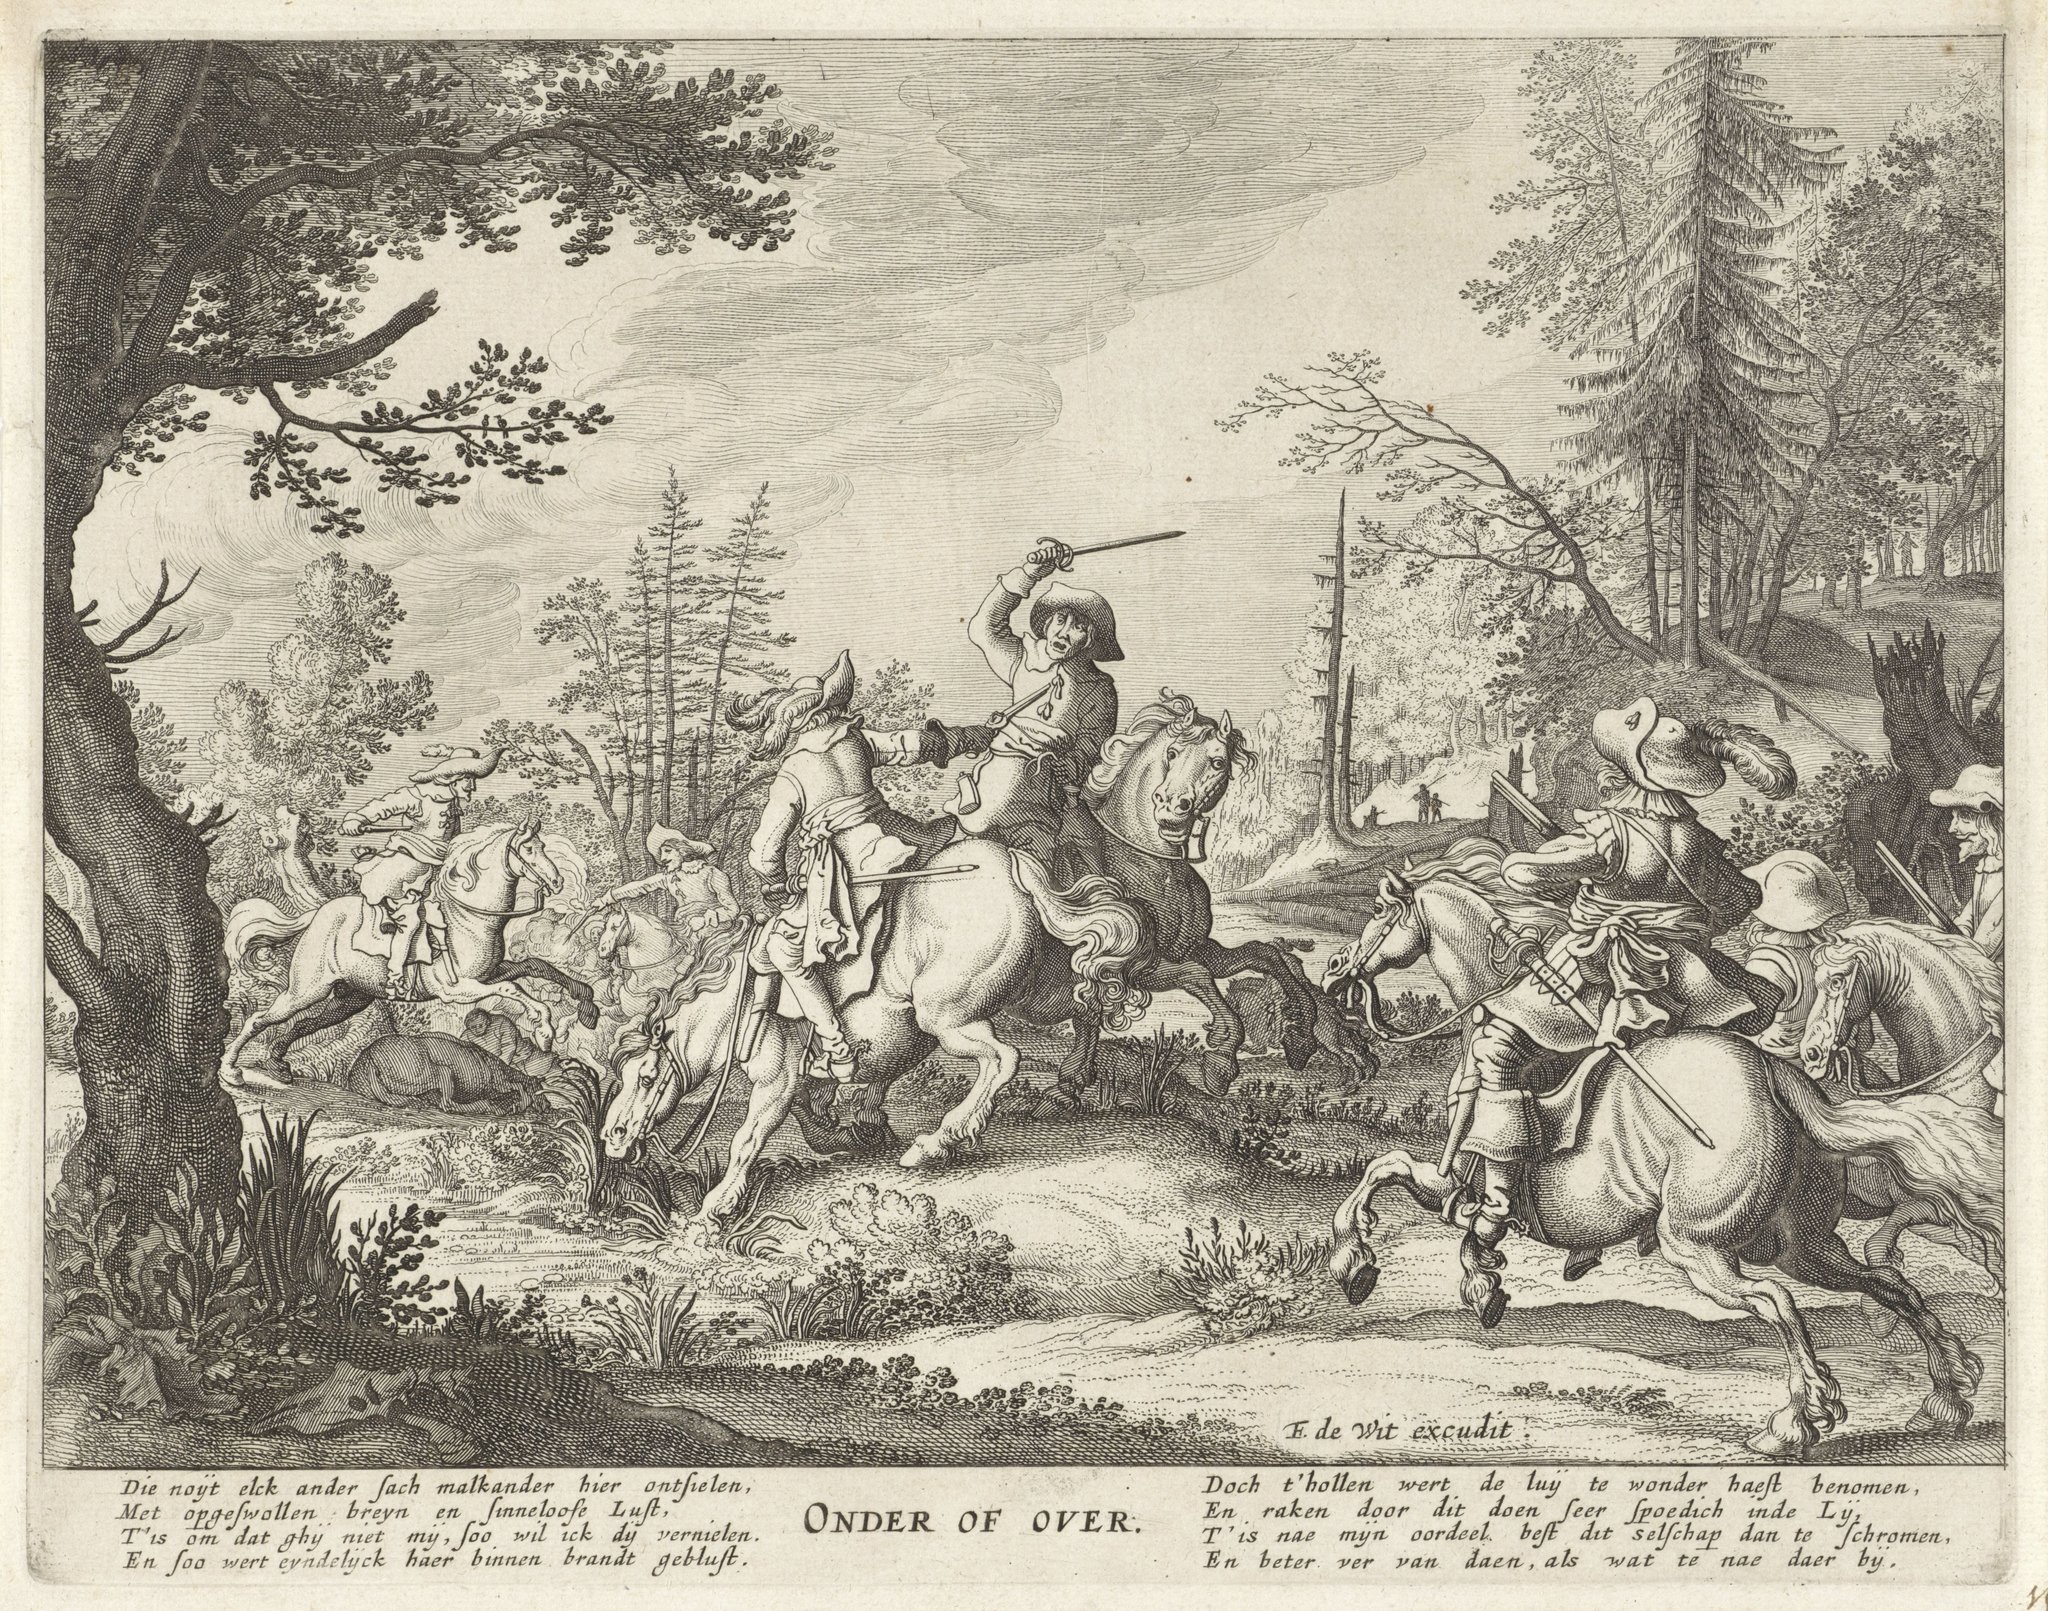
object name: print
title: Onder of over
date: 1630-1706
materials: paper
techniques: engraving, etching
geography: amsterdam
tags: glade, 'lichtung im wald', battle (+ cavalry, horsemen)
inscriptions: collector's mark: Lugt 2228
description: Op een open plek in het bos strijden enkele cavaleristen tegen elkaar. Onderaan een achtregelig gedicht in het Nederlands.